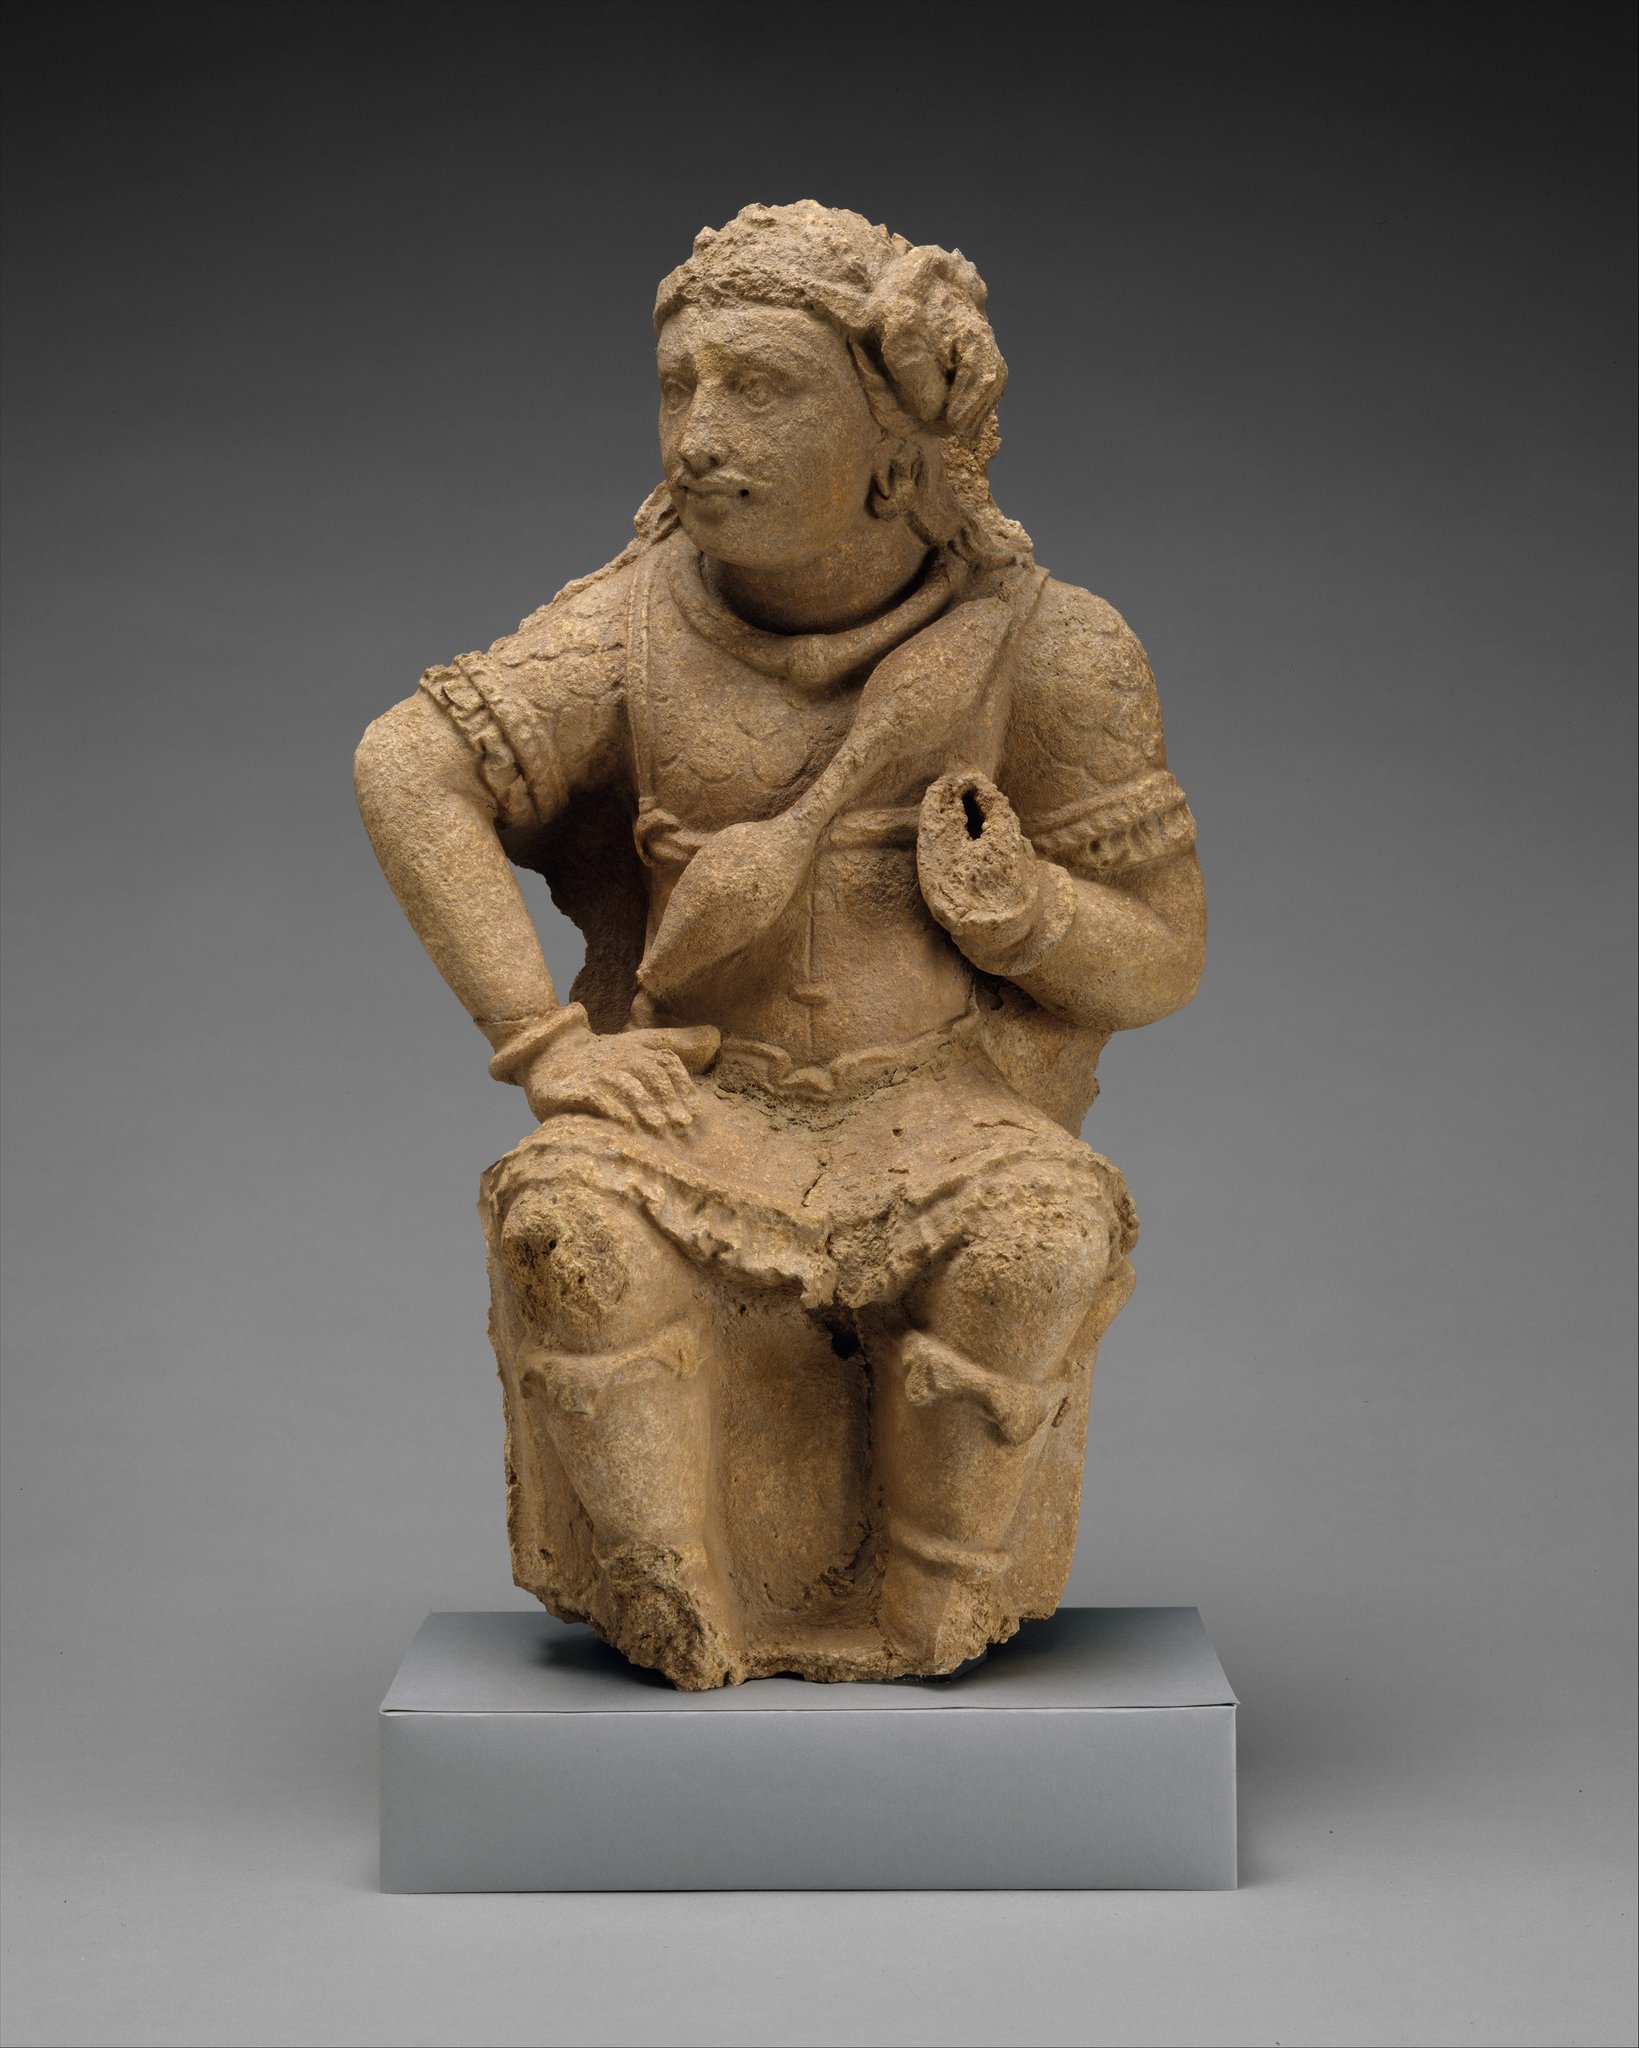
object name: figure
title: Door Guardian (Dvarapala)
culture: gandhara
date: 301-400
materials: plaster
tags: gandhara,men